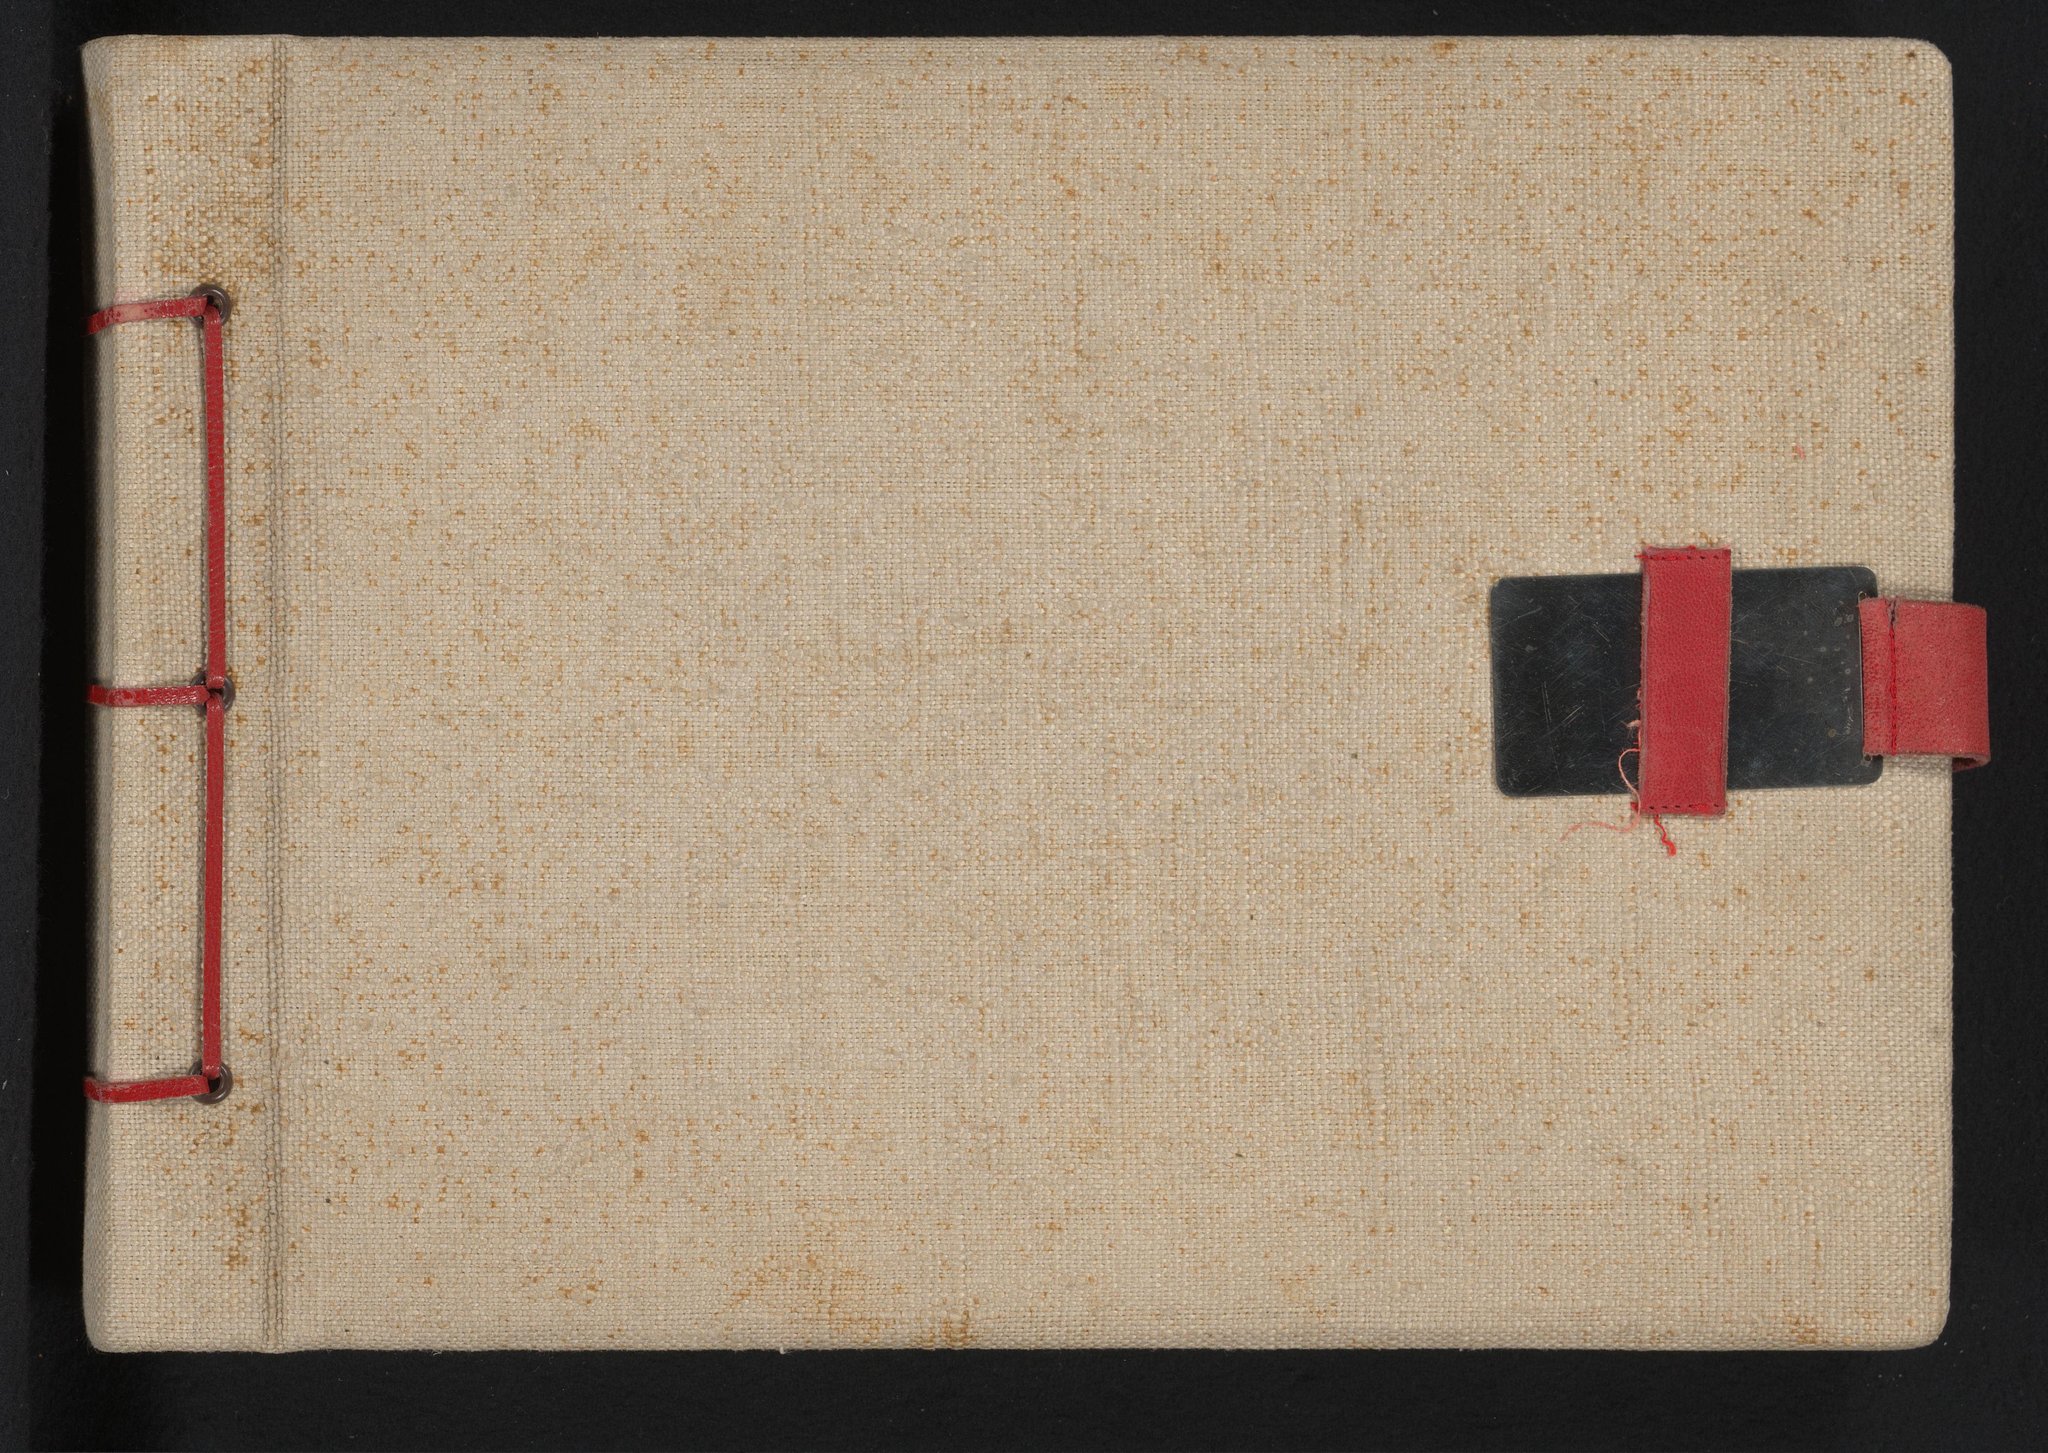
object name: slip in album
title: Fotoalbum Wehrmacht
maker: Anonymous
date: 1938-1941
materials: cardboard, linen, metal, photographic support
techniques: gelatin silver print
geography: france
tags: germany, rotterdam, france, belgium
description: Fotoalbum met een beige linnen kaft en een rood leren veter door de rug. Sluiting aan de voorkant van metaal, het lipje is stuk. De inhoud bevat 24 bladen van donkerbruin karton, waarvan de laatste zes enkele leeg zijn. Het album bevat in totaal 53 foto's en prentbriefkaarten. Pergamijn tussen de pagina's. Het album begint met foto's uit 1938 in Duitsland. In mei 1940 volgt de invasie in Nederland, met foto's van Rotterdam, de Moerdijkbrug e.d. daarna trekt men door België en Frankrijk met foto's van krijgsgevangenen uit de Britse koloniën. Sommige foto's hebben op de achterzijde opschriften geschreven in Sütterlin.